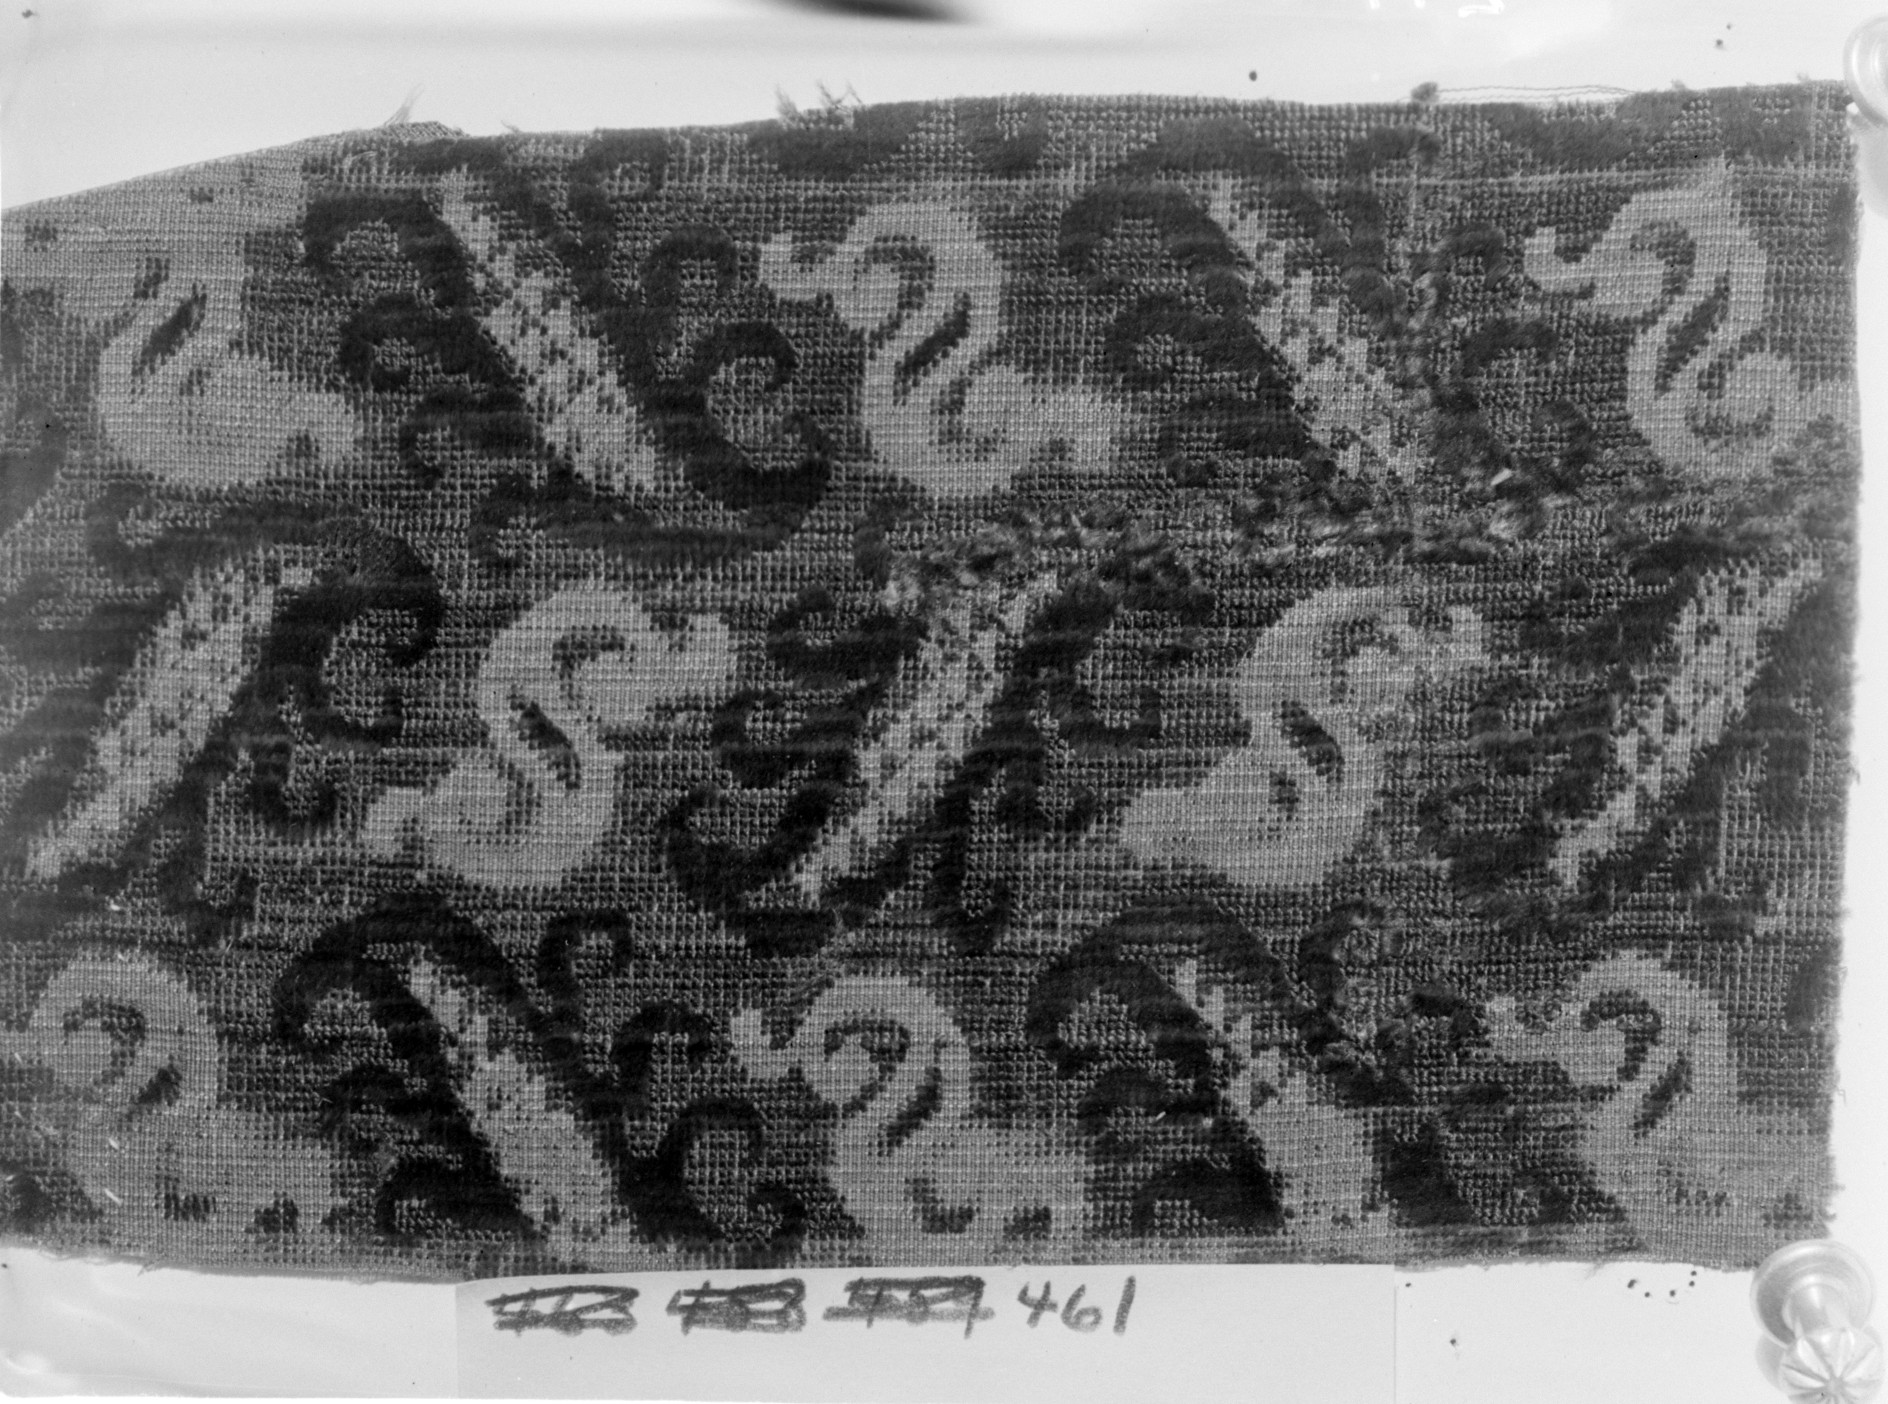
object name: piece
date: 1501-1700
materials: silk